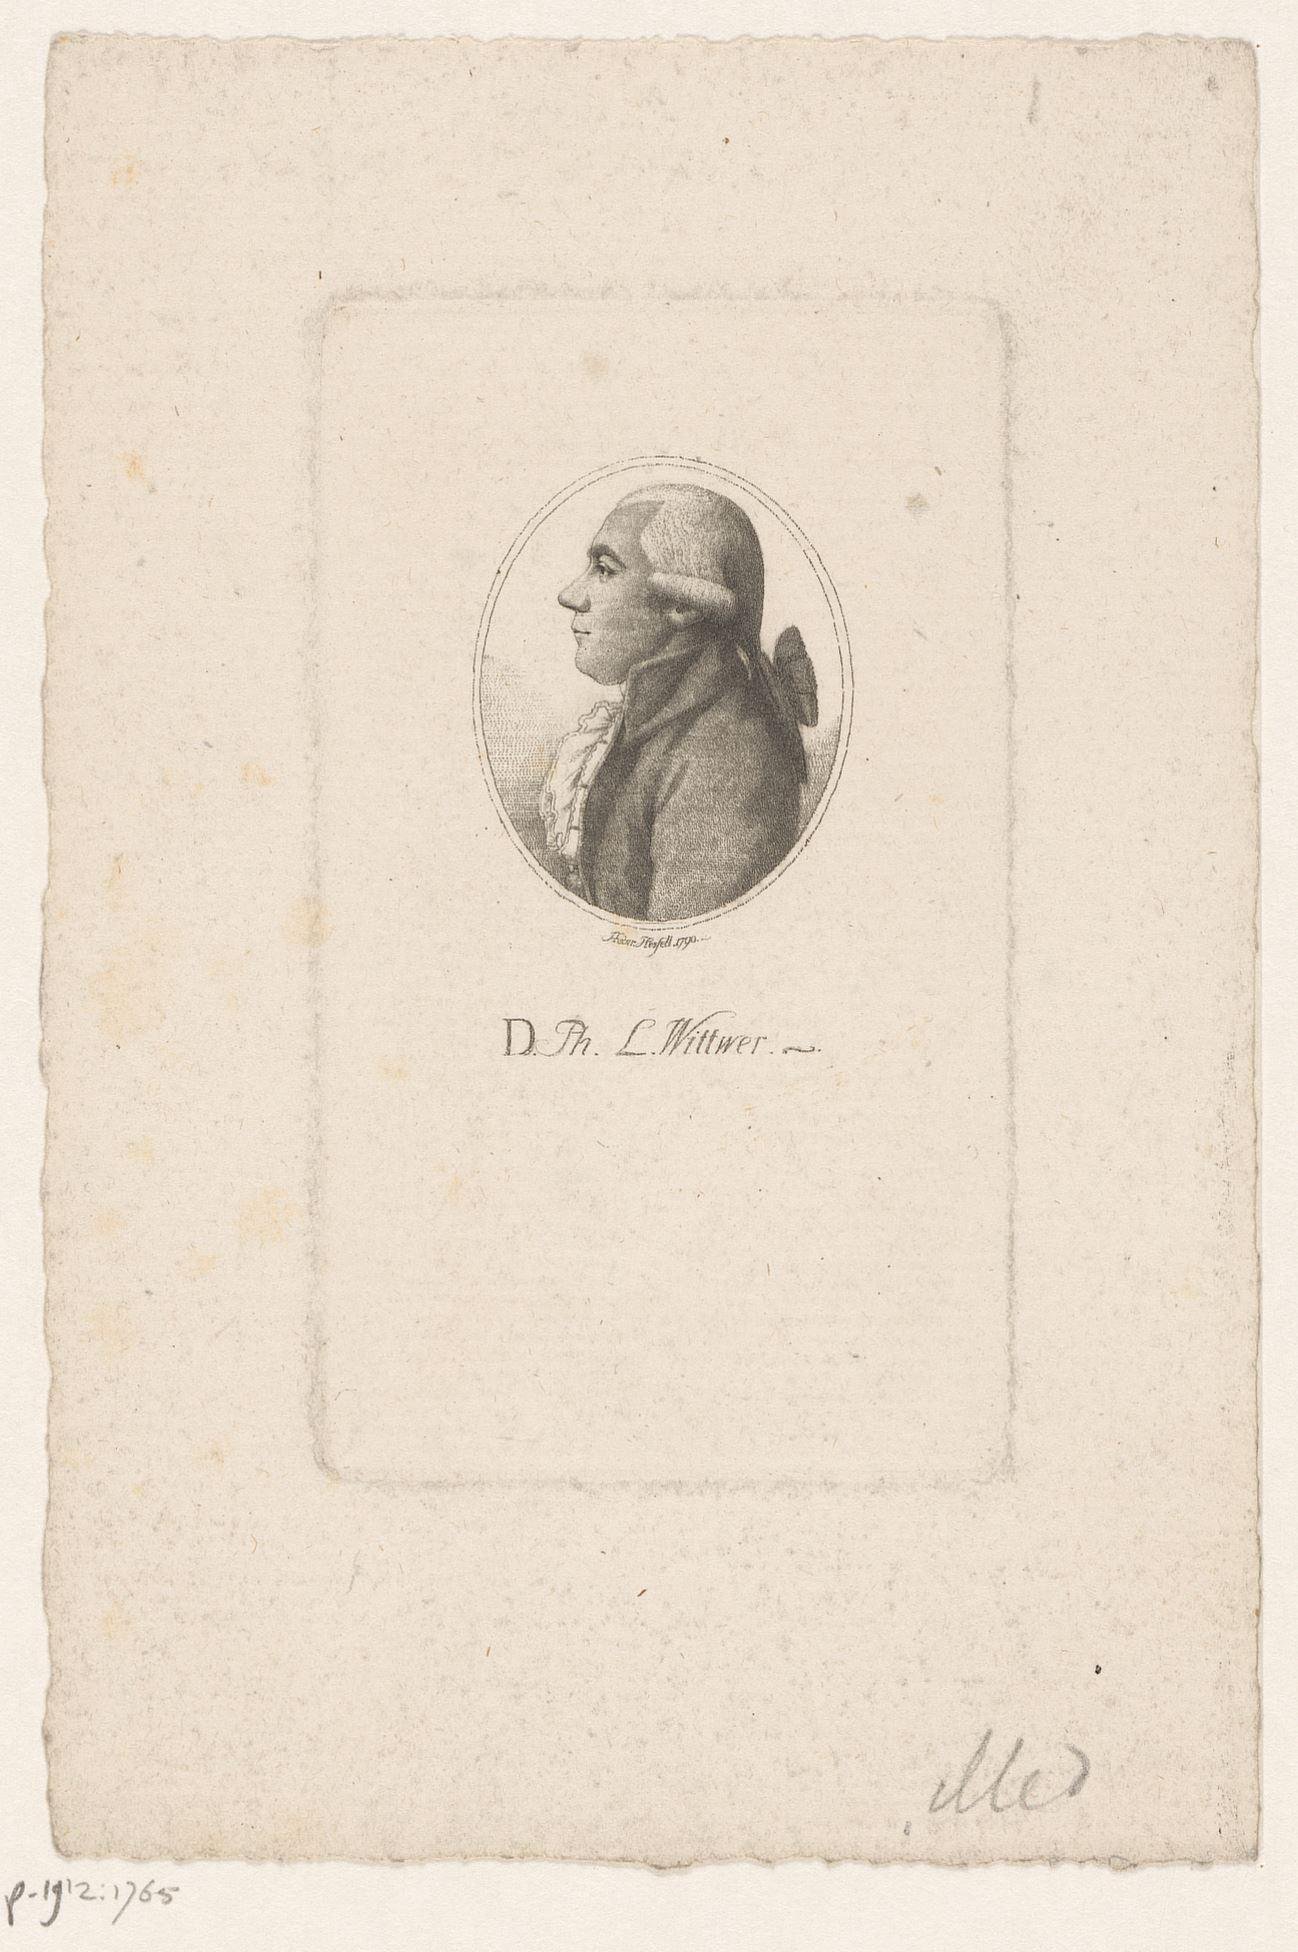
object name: print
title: Portret van Philipp Ludwig Wittwer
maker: leonhard heinrich hessell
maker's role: musical instrument maker, painter, print maker, publisher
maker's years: 1757-1830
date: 1790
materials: paper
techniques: aquatint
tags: historical persons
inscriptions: collector's mark: Lugt 2228